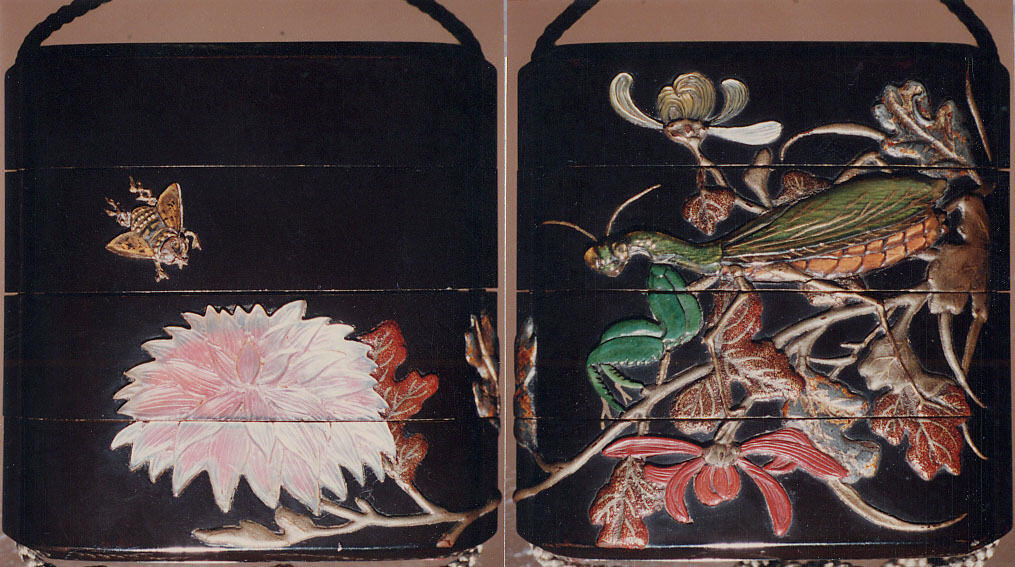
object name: inrō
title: Case (Inrō) with Design of Chrysanthemum and Bee (obverse); Praying Mantis (reverse)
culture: japanese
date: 1701-1900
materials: ceramic, gold, lacquer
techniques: fundame, hiramakie, inlay, roiro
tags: insects,bees,flowers